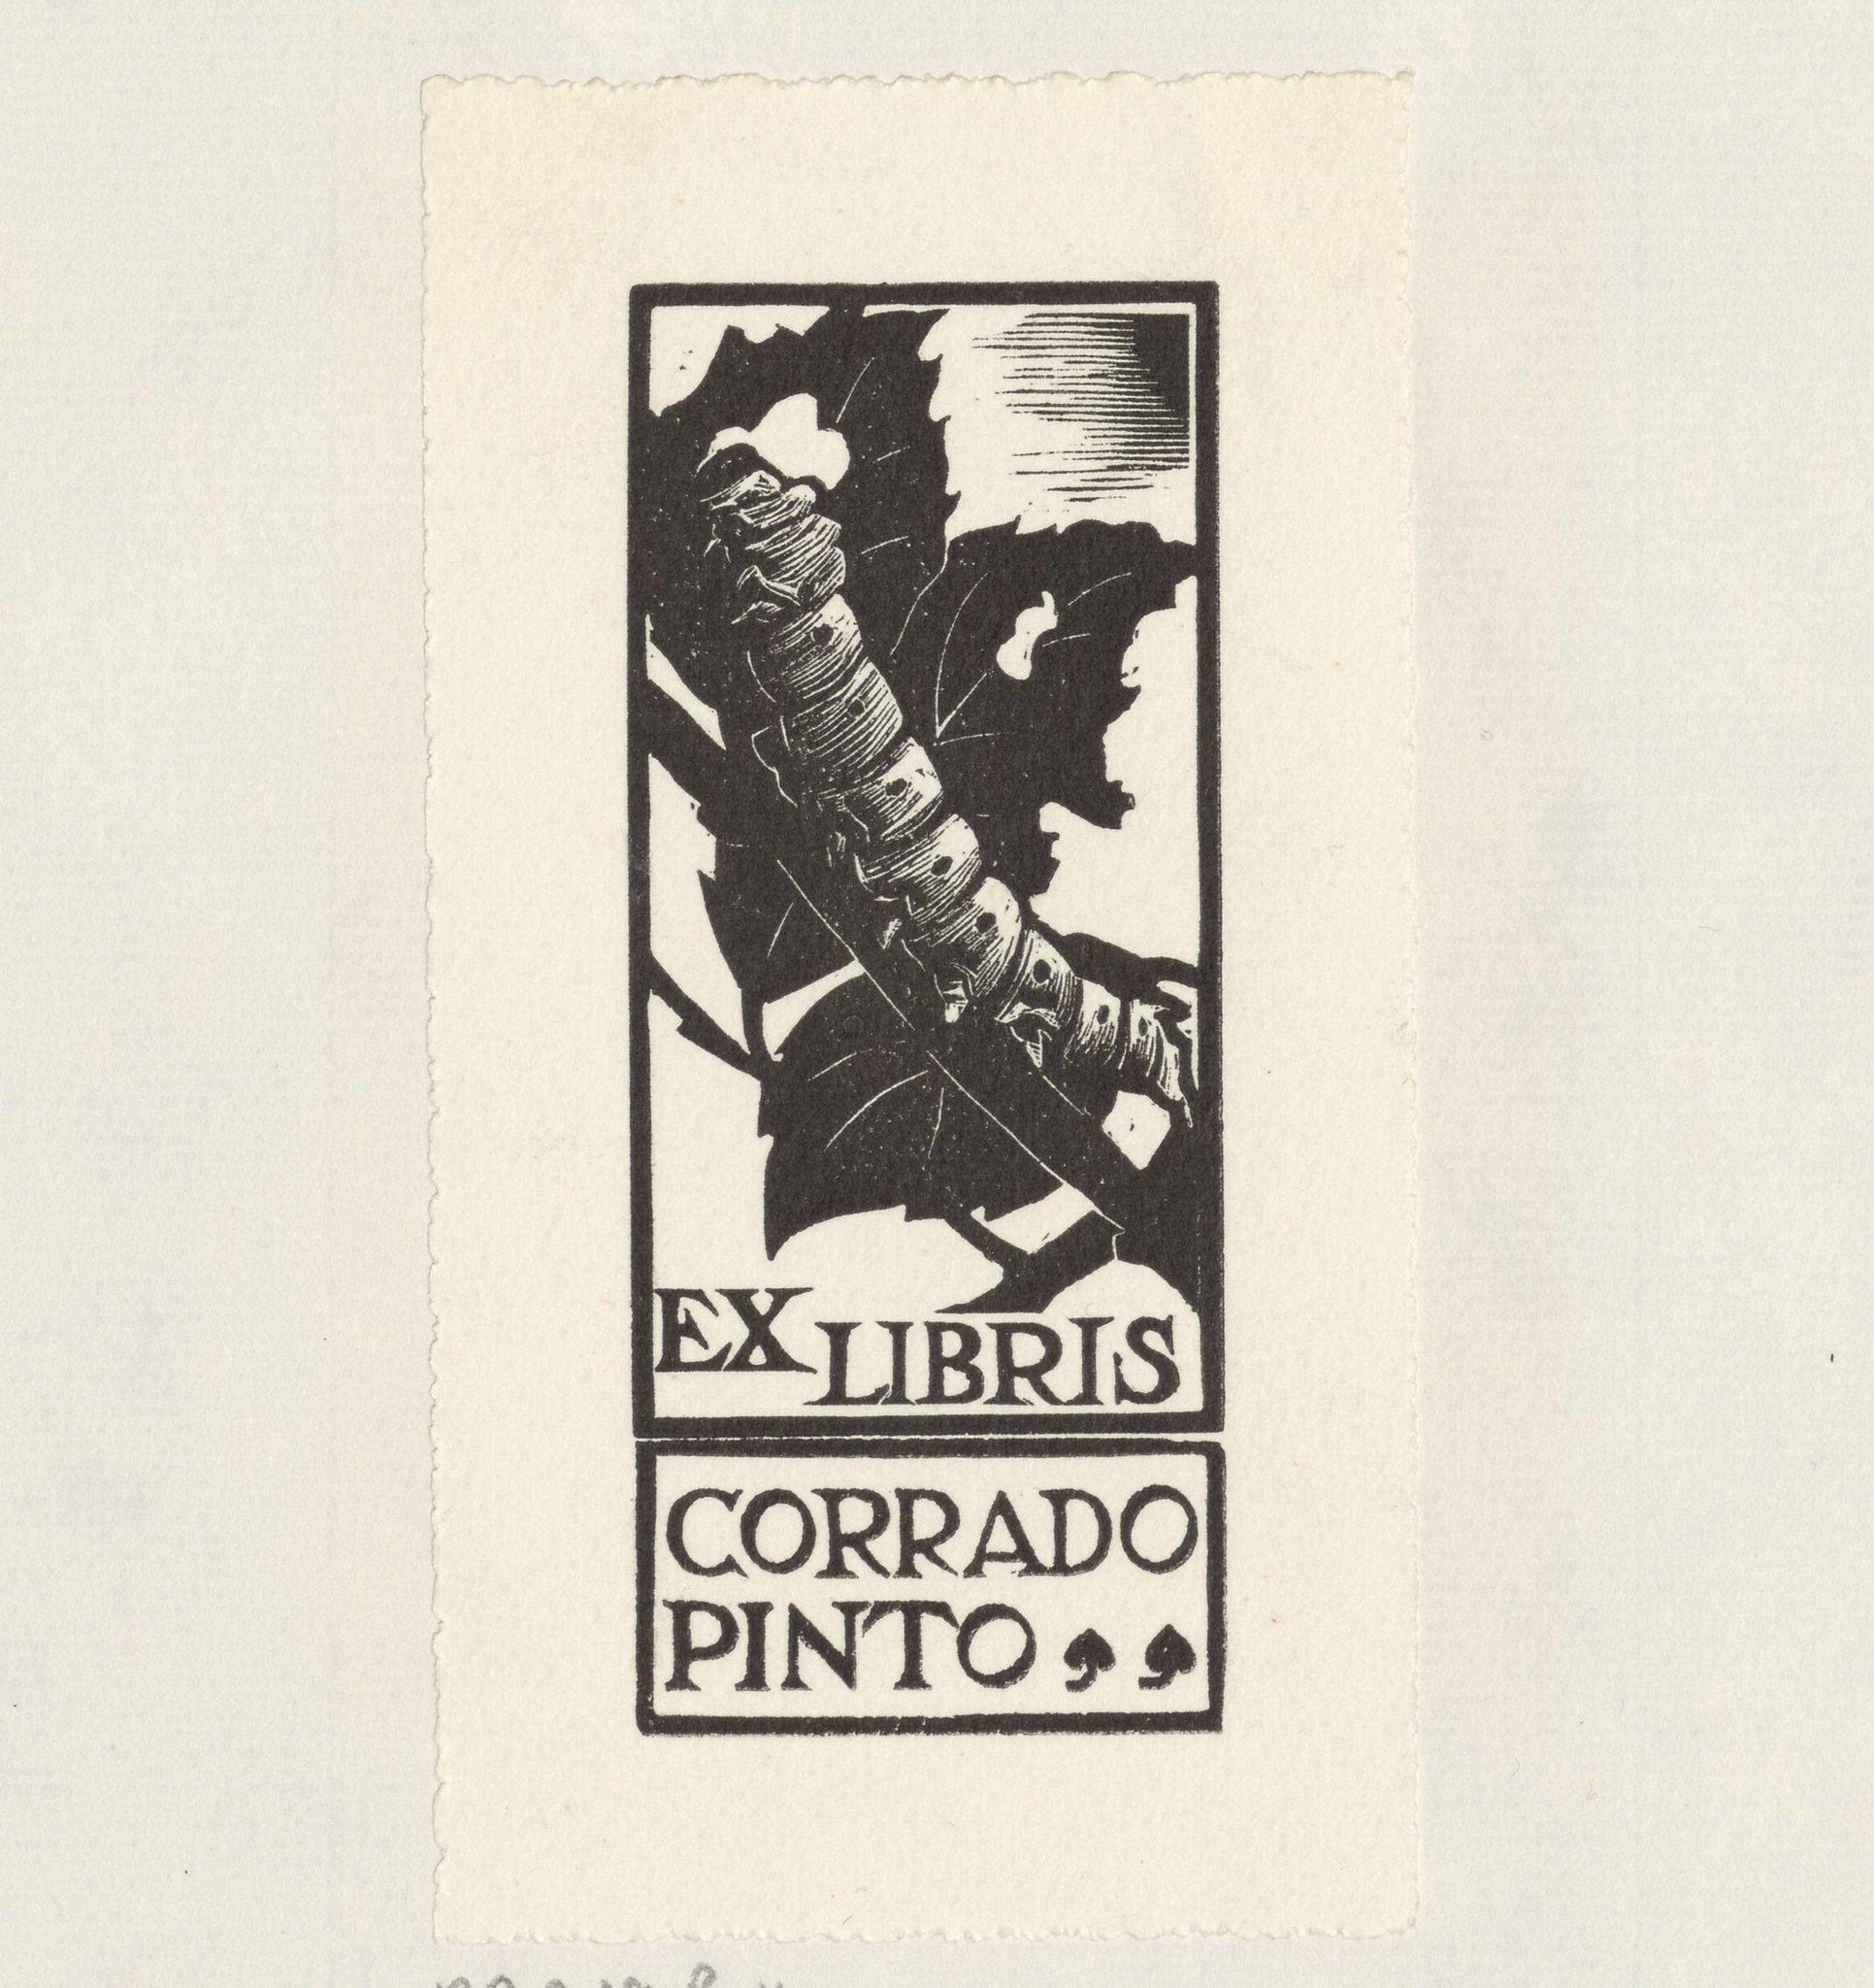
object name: bookplate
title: Ex libris van Corrado Pinto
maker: Anonymous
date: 1900-1999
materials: paper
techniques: woodcut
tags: insects: caterpillar, plants and herbs